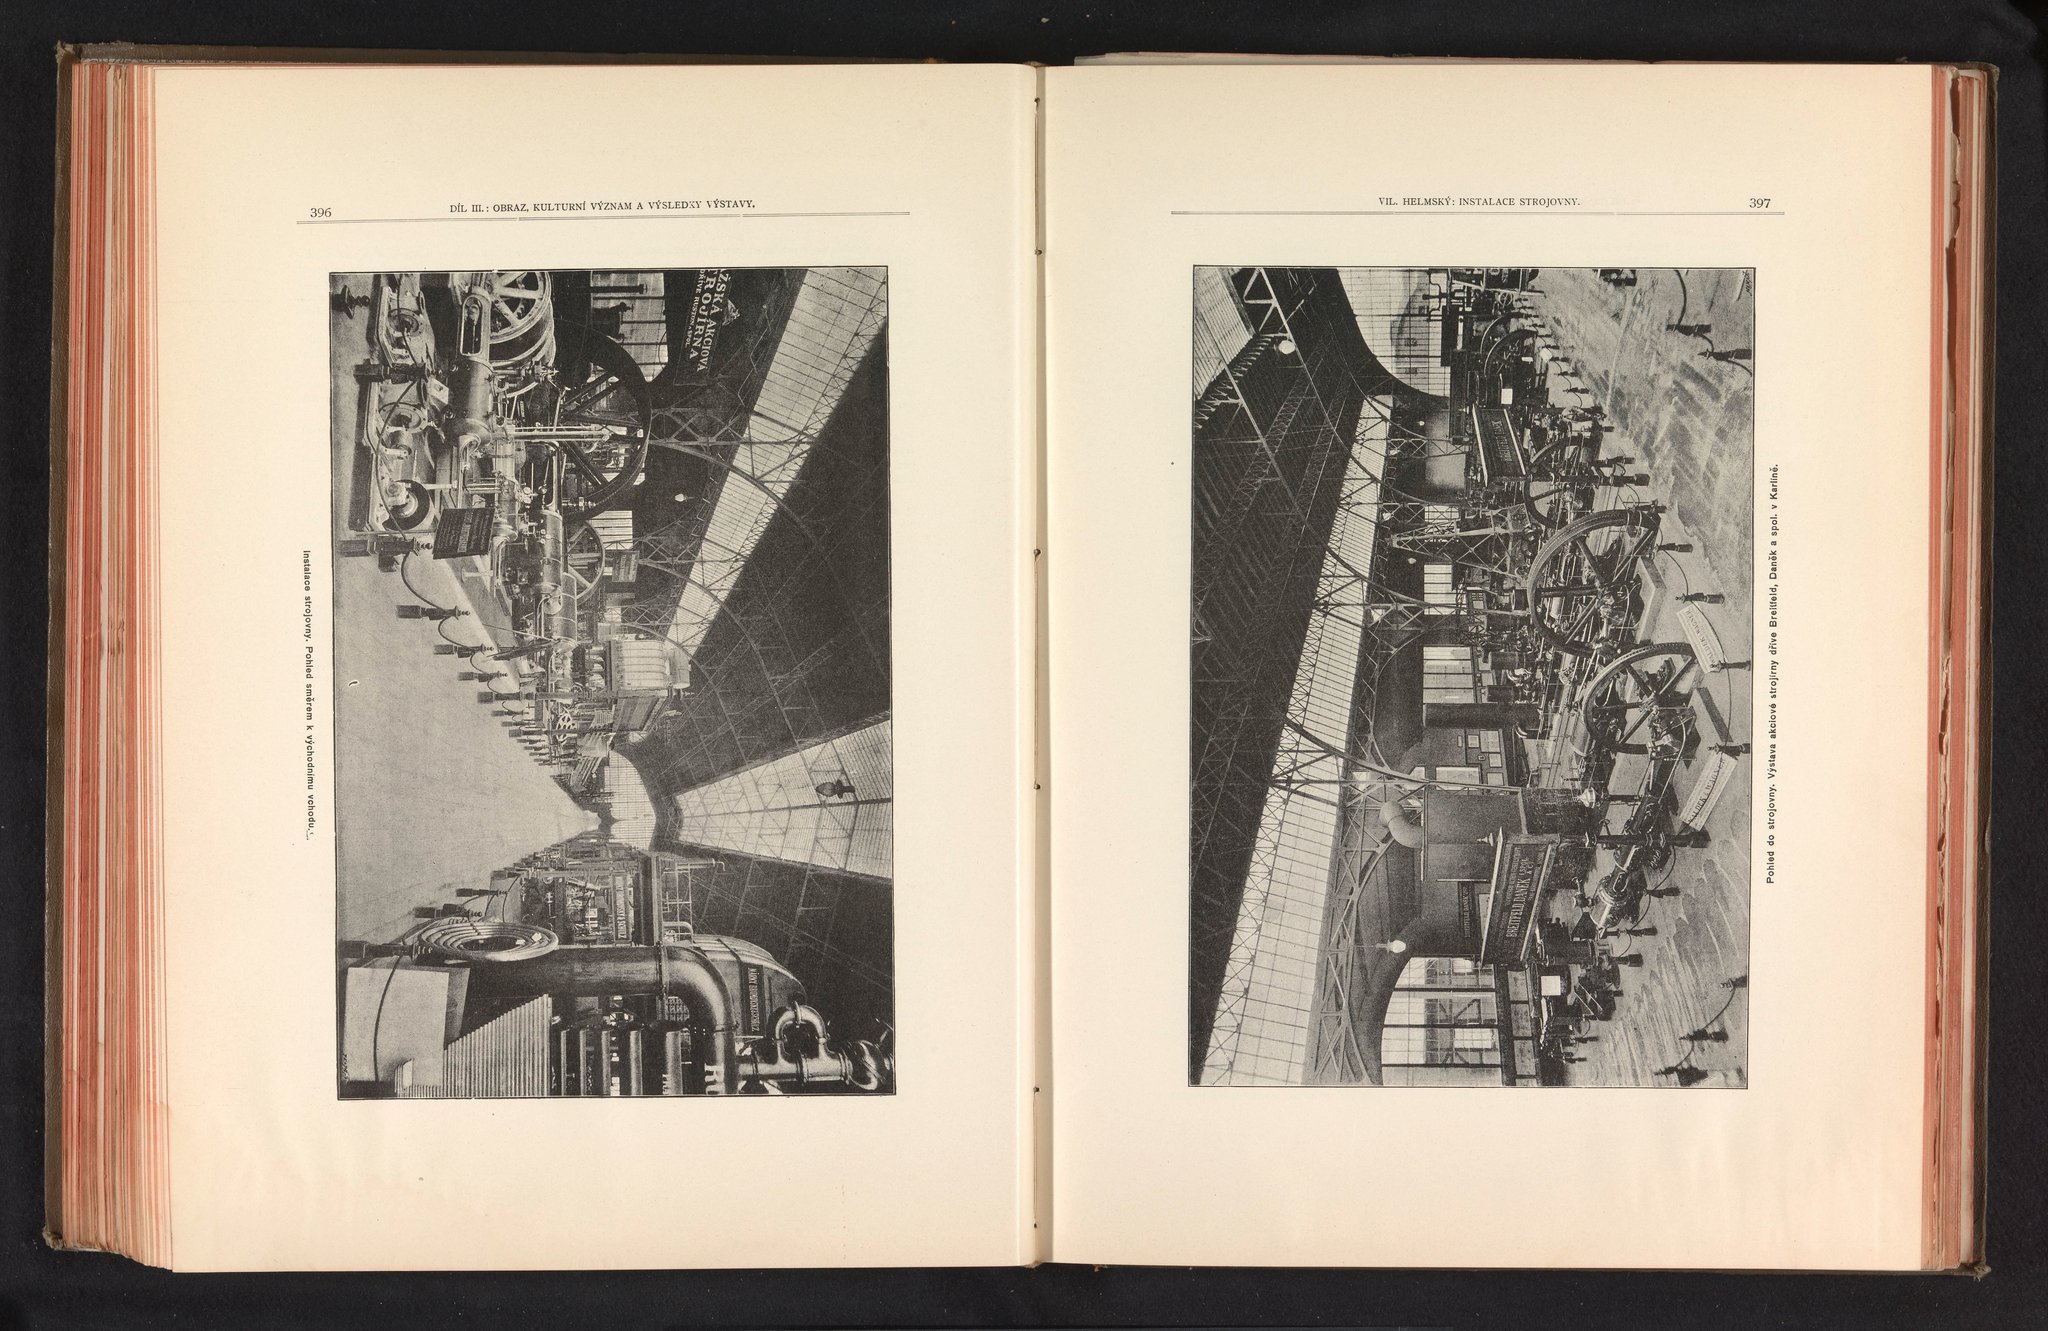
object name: photomechanical print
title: Pohled do strojovny. Výstava akciové strojirny drive Breitfeld, Danek a spol. v Katrine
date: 1890-1895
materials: paper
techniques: autotype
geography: prague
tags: machines; parts of machines; tools and appliances, interior ~ representation of a building